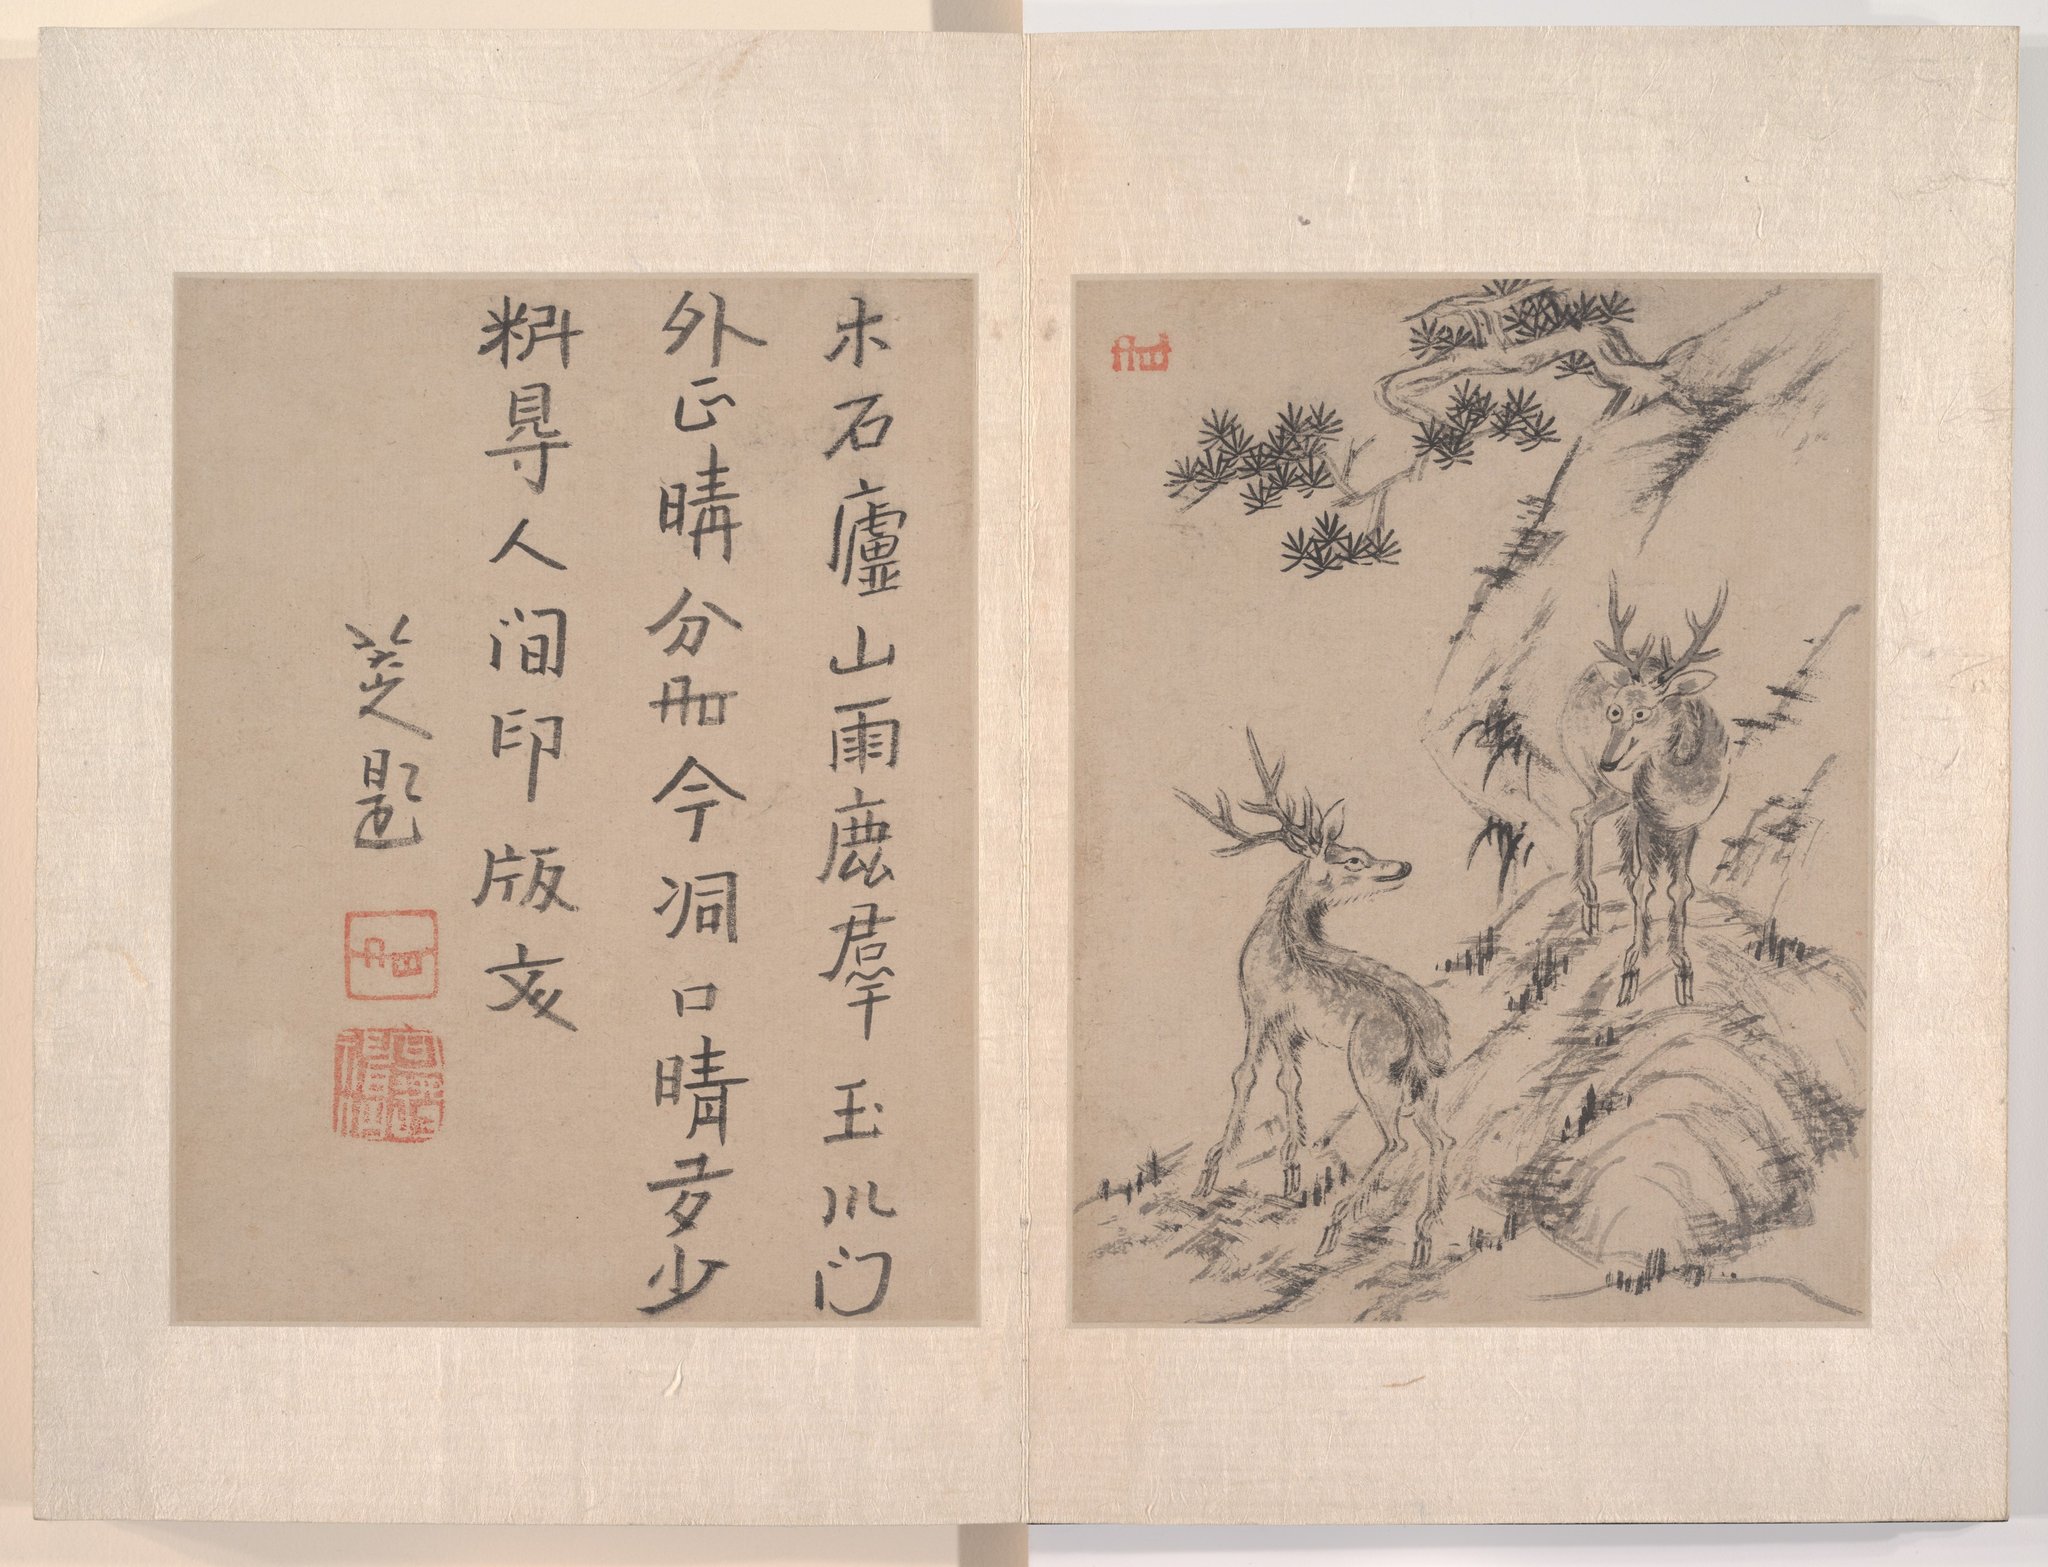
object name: album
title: Album of miscellaneous paintings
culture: chinese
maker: bada shanren (zhu da)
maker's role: artist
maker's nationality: chinese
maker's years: 1626-1705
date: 1644-1705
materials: ink, paper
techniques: painting, wash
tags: birds,deer,fish,plants